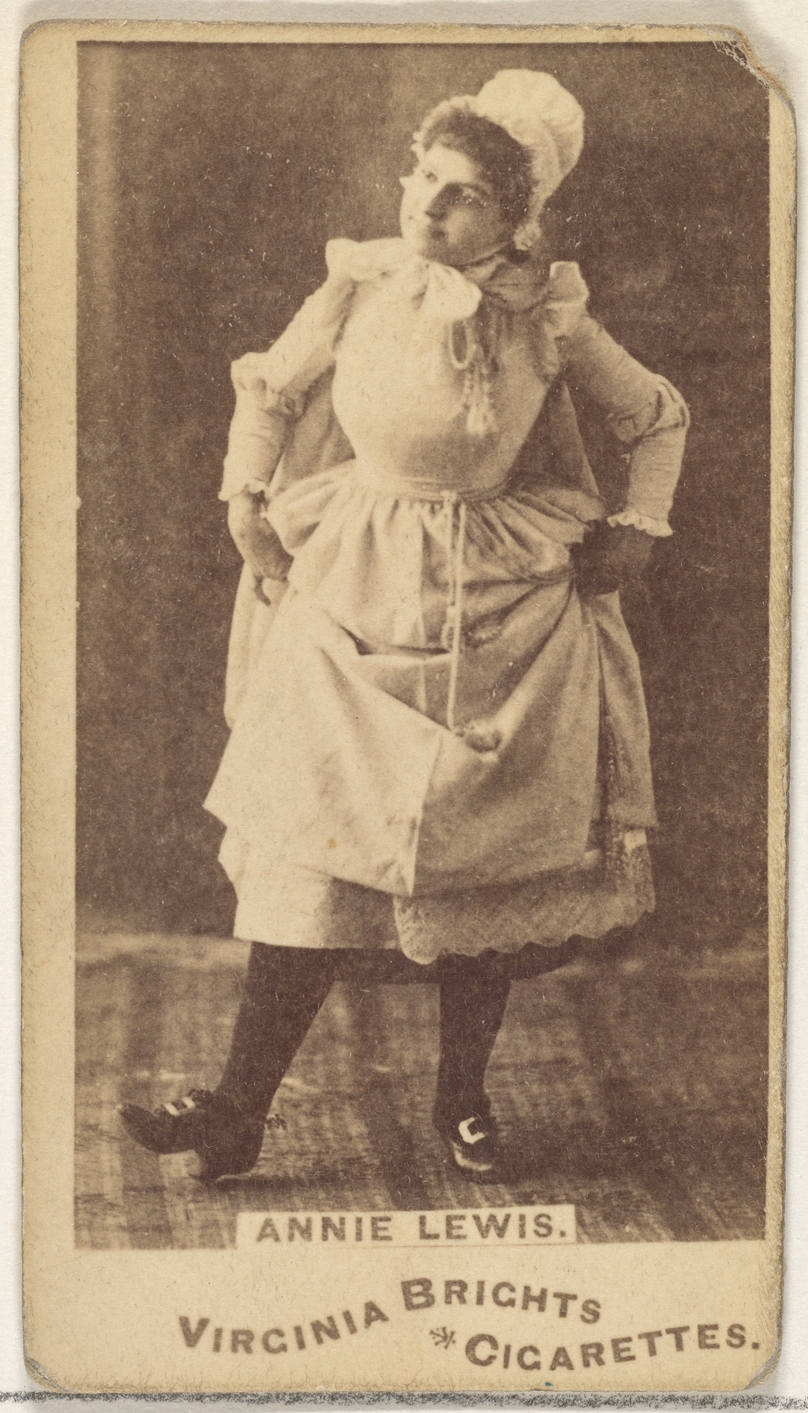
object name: photograph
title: Annie Lewis, from the Actors and Actresses series (N45, Type 1) for Virginia Brights Cigarettes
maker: allen & ginter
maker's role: publisher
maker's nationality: american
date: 1888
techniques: albumen silver print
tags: portraits,women,actresses